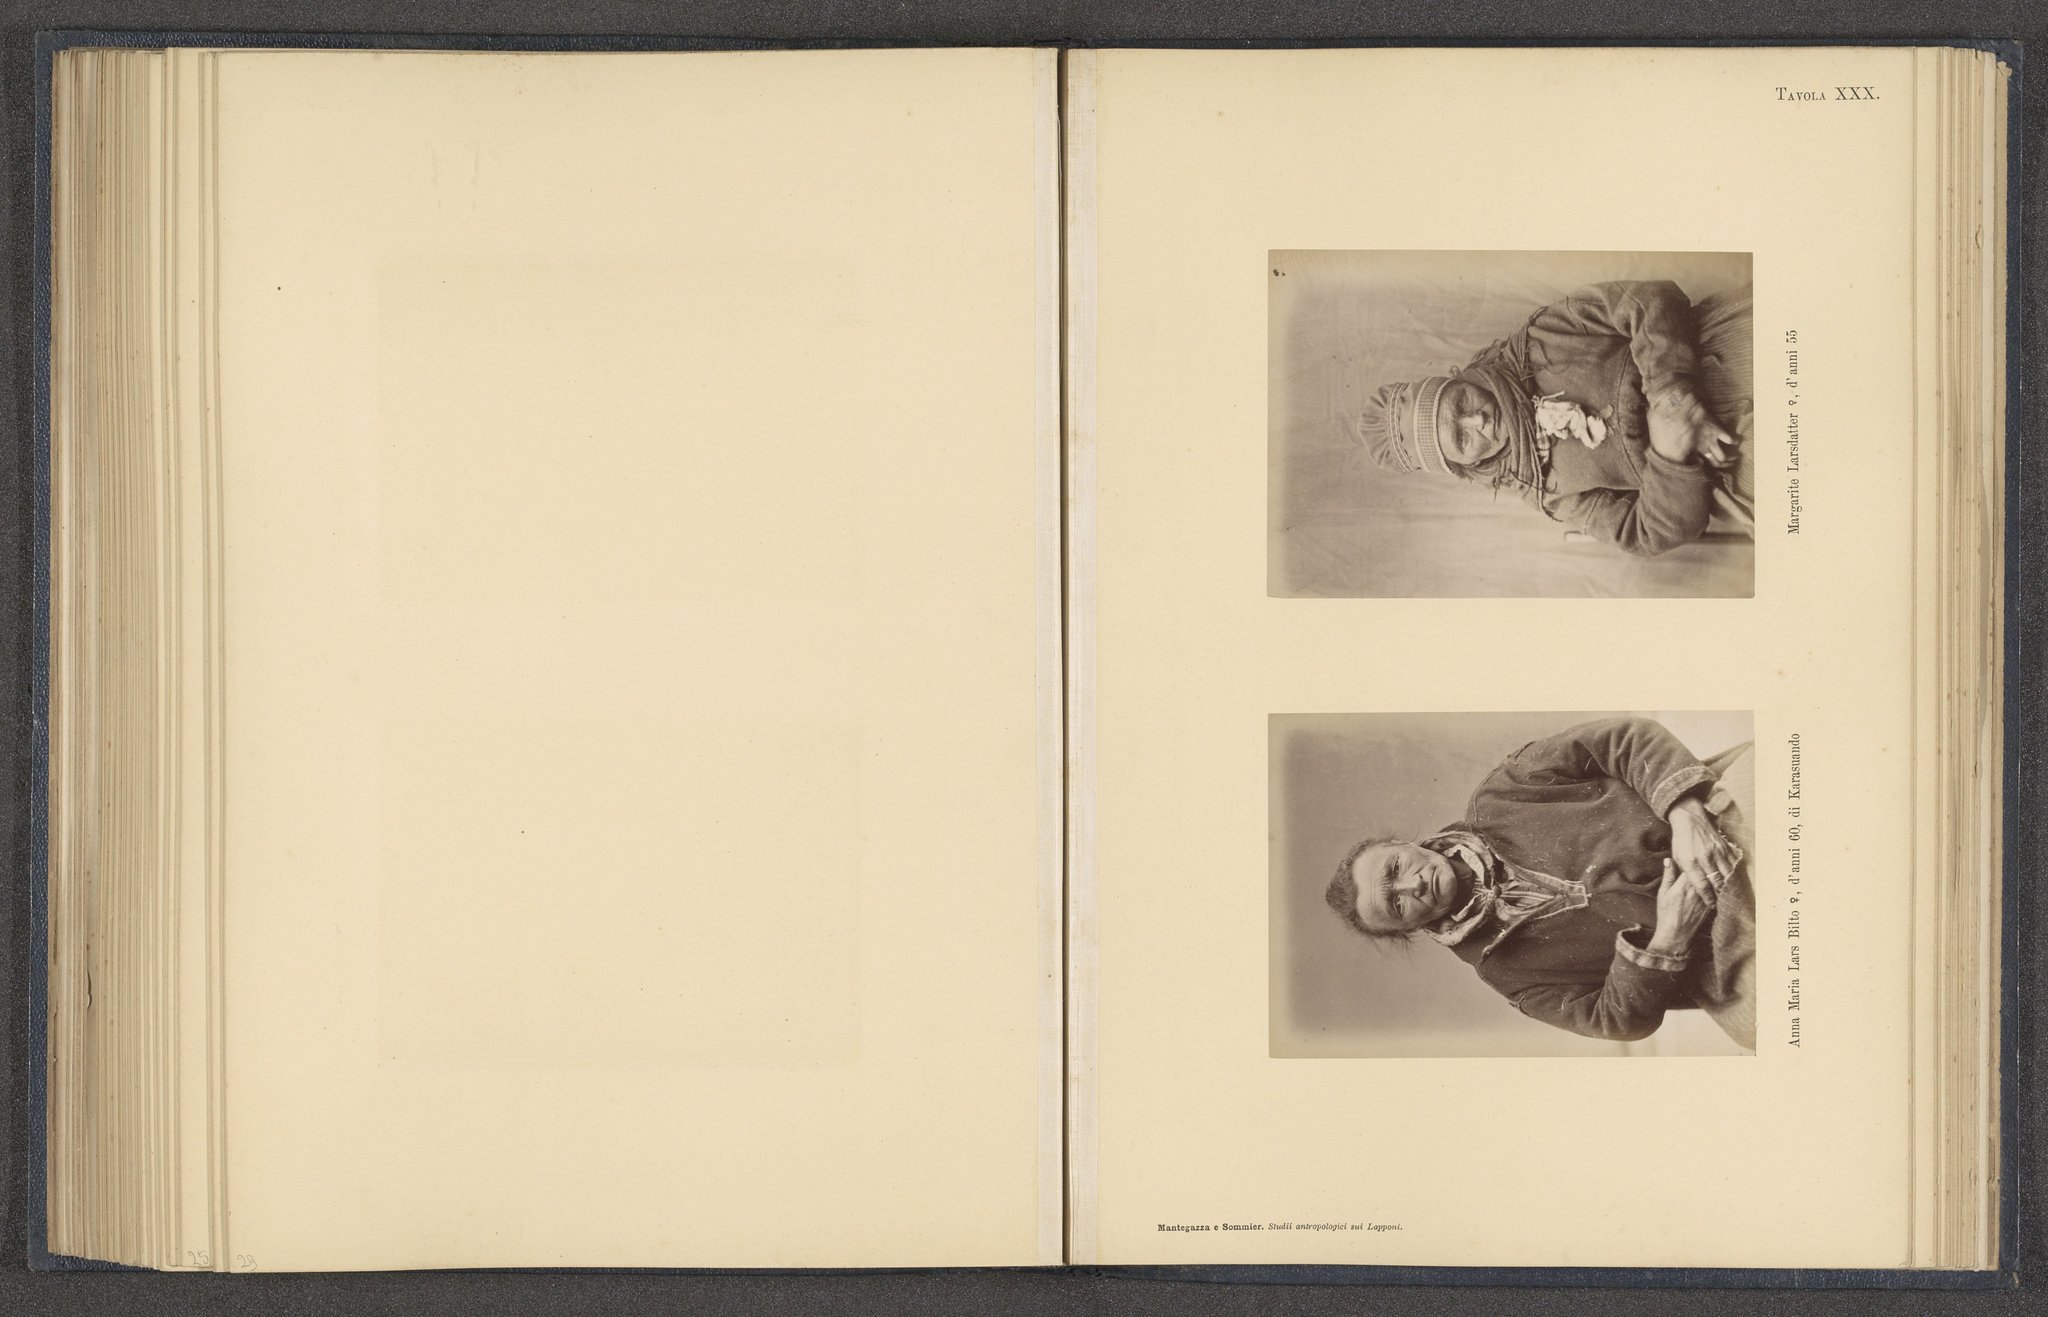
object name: page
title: Twee portretten van Anna Maria Lars Bilto en Margarite Larsdatter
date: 1870-1880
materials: paper, photographic support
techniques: albumen print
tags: head-gear, adult woman (+ front view)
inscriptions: number: ‘Tavola XXX.’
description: Links een vooraanzicht van Anna Maria Lars Bilto, rechts een vooraanzicht van Margarite Larsdatter.